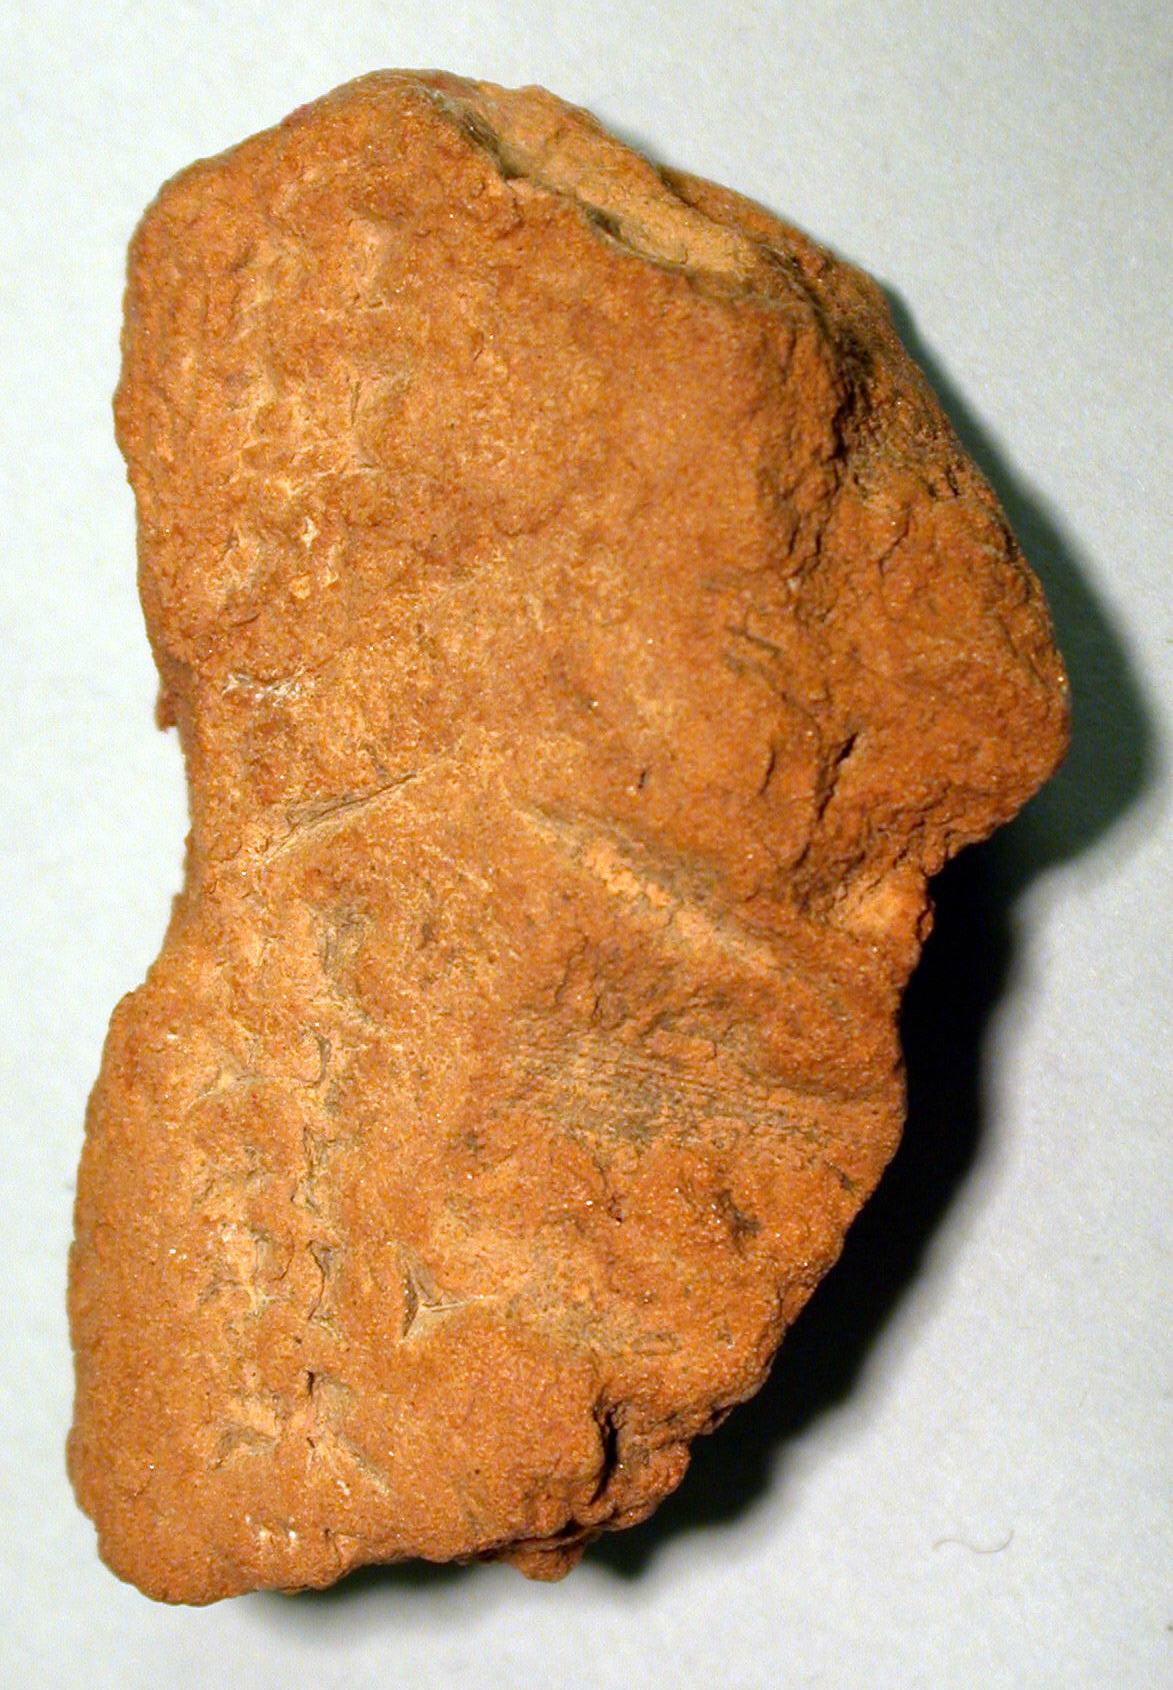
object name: cuneiform tablet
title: Cuneiform tablet: fragment of Syllabary A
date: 333-1 BCE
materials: clay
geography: mesopotamia